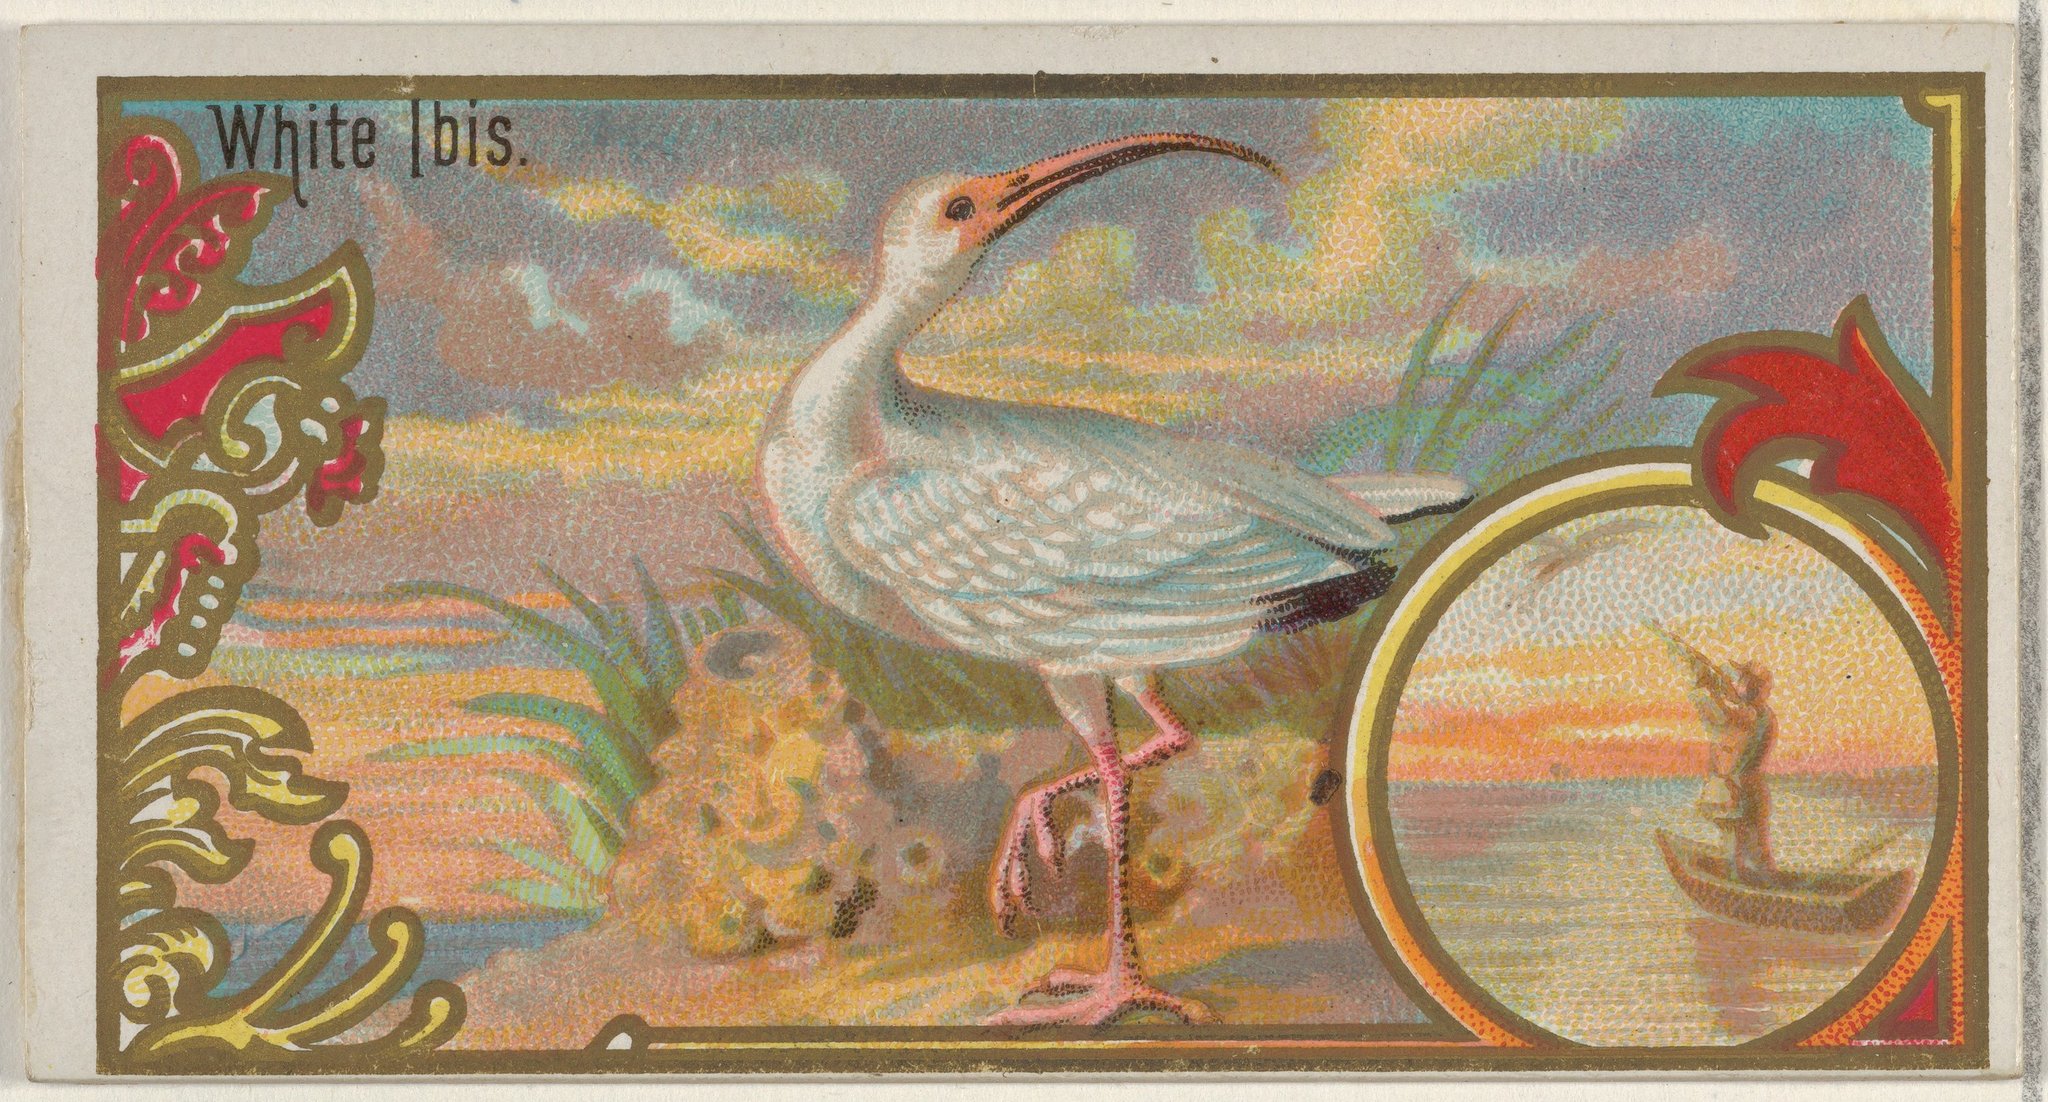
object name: print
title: White Ibis, from the Game Birds series (N13) for Allen & Ginter Cigarettes Brands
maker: allen & ginter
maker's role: publisher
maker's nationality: american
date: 1889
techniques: color lithograph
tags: birds